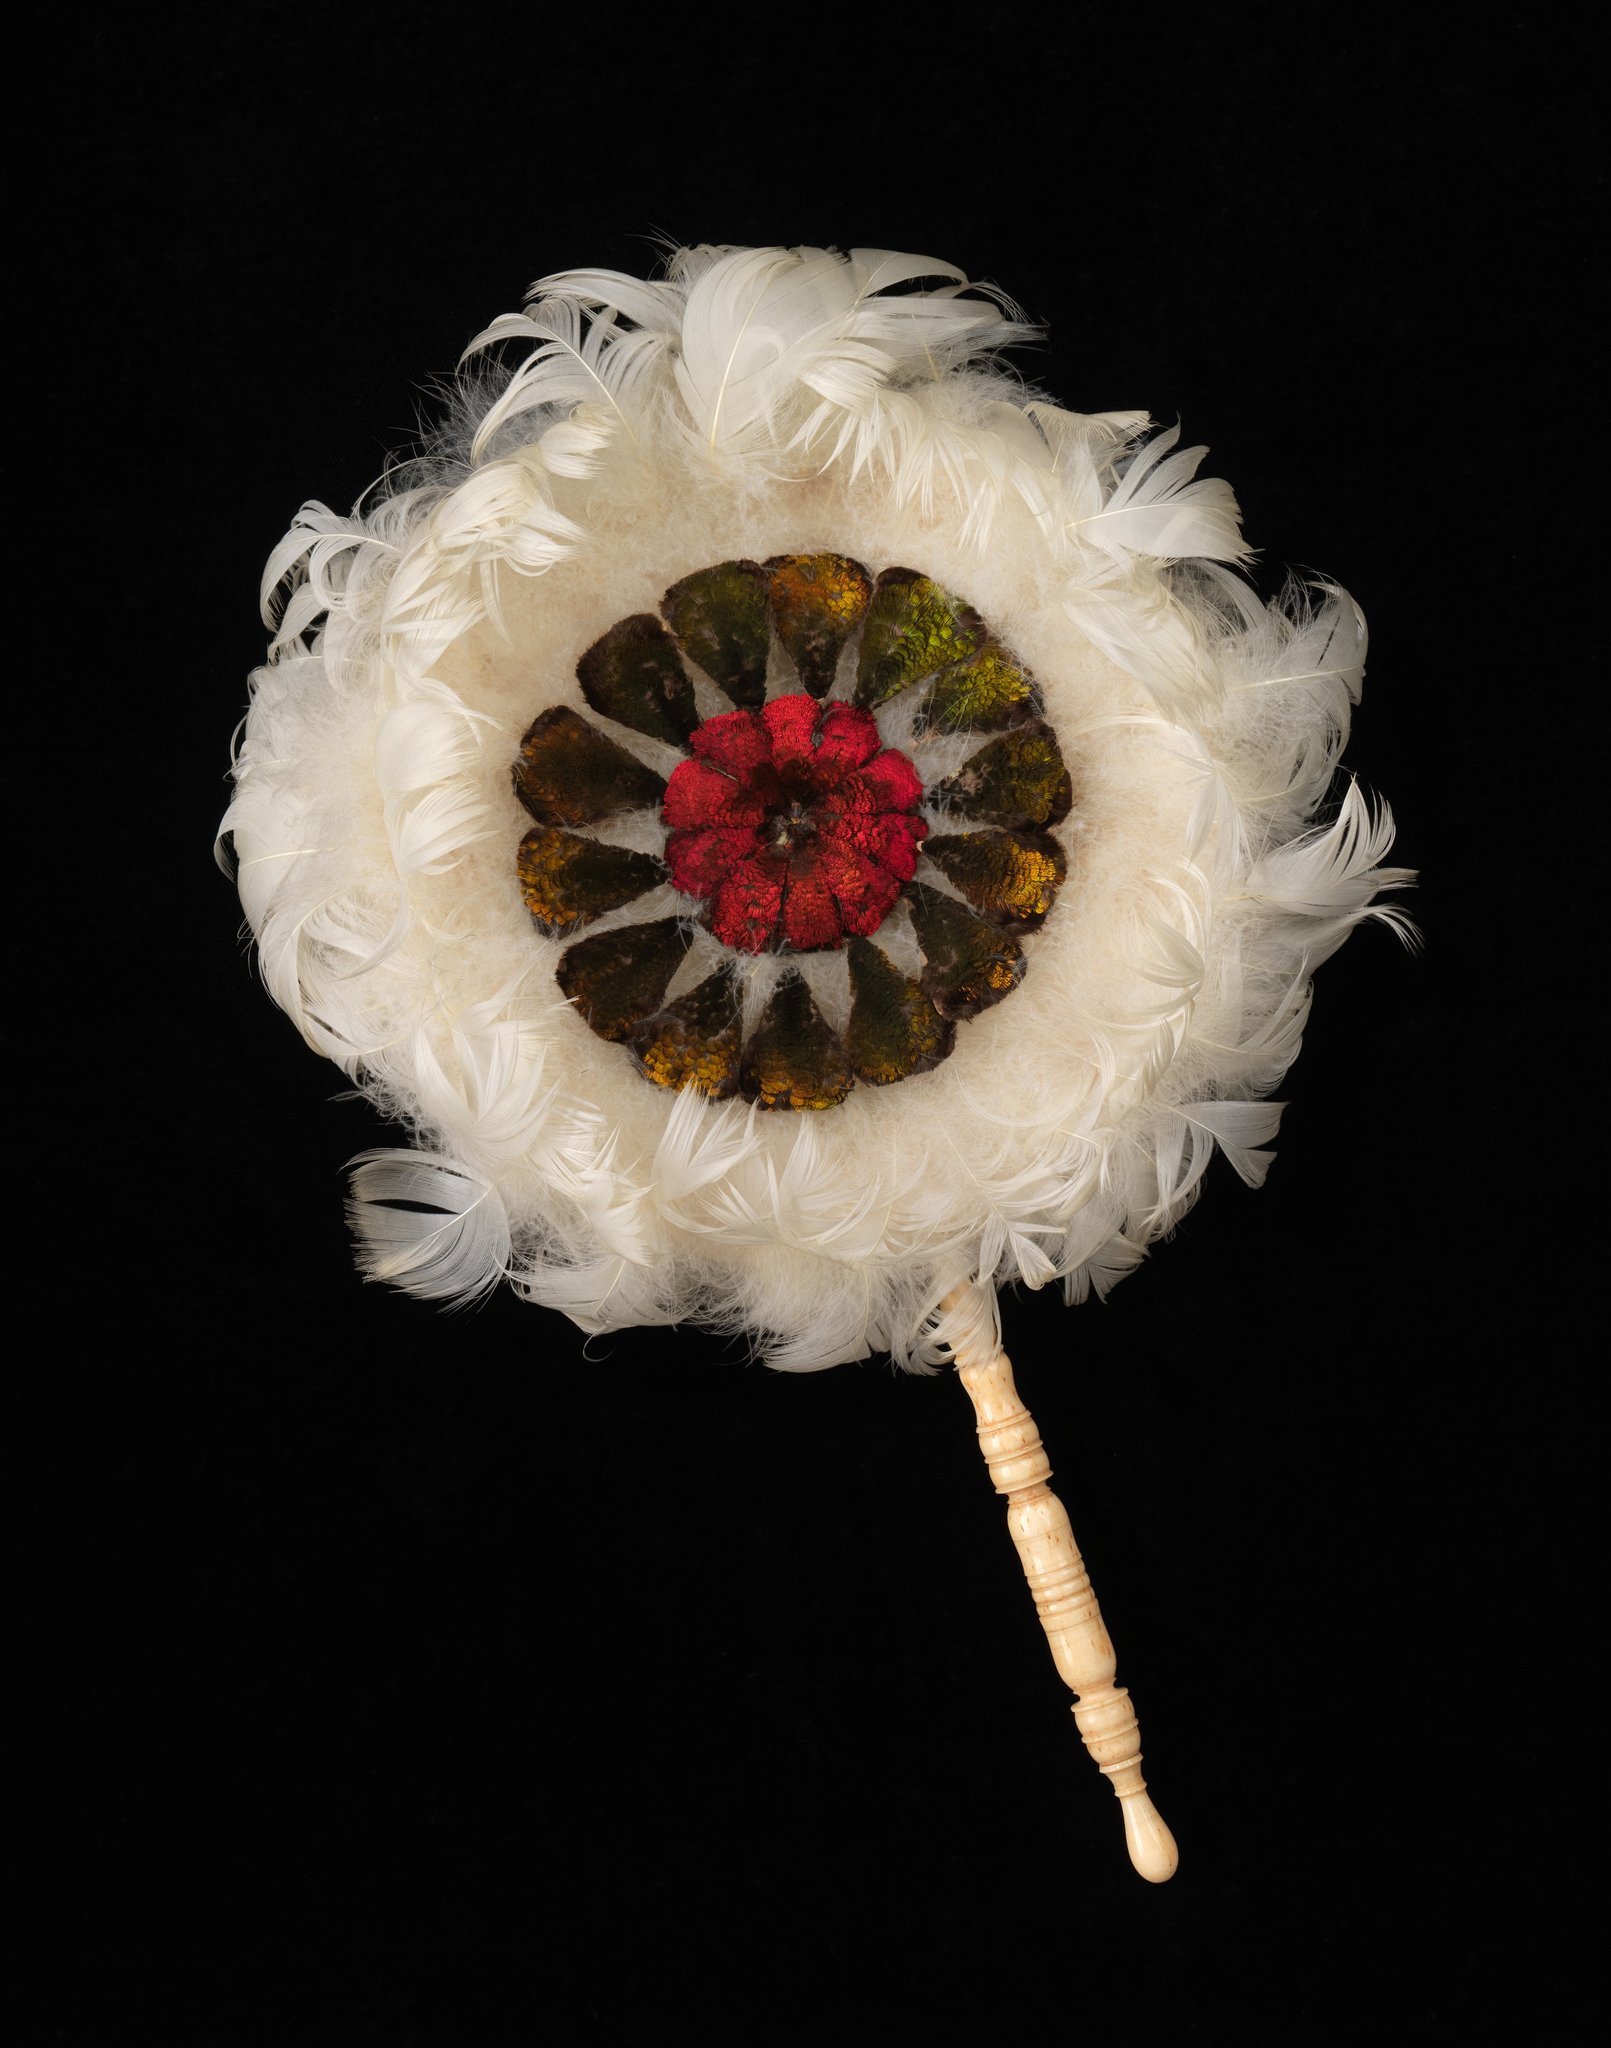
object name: fixed fan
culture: brazilian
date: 1865-1875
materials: feather, ivory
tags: flowers